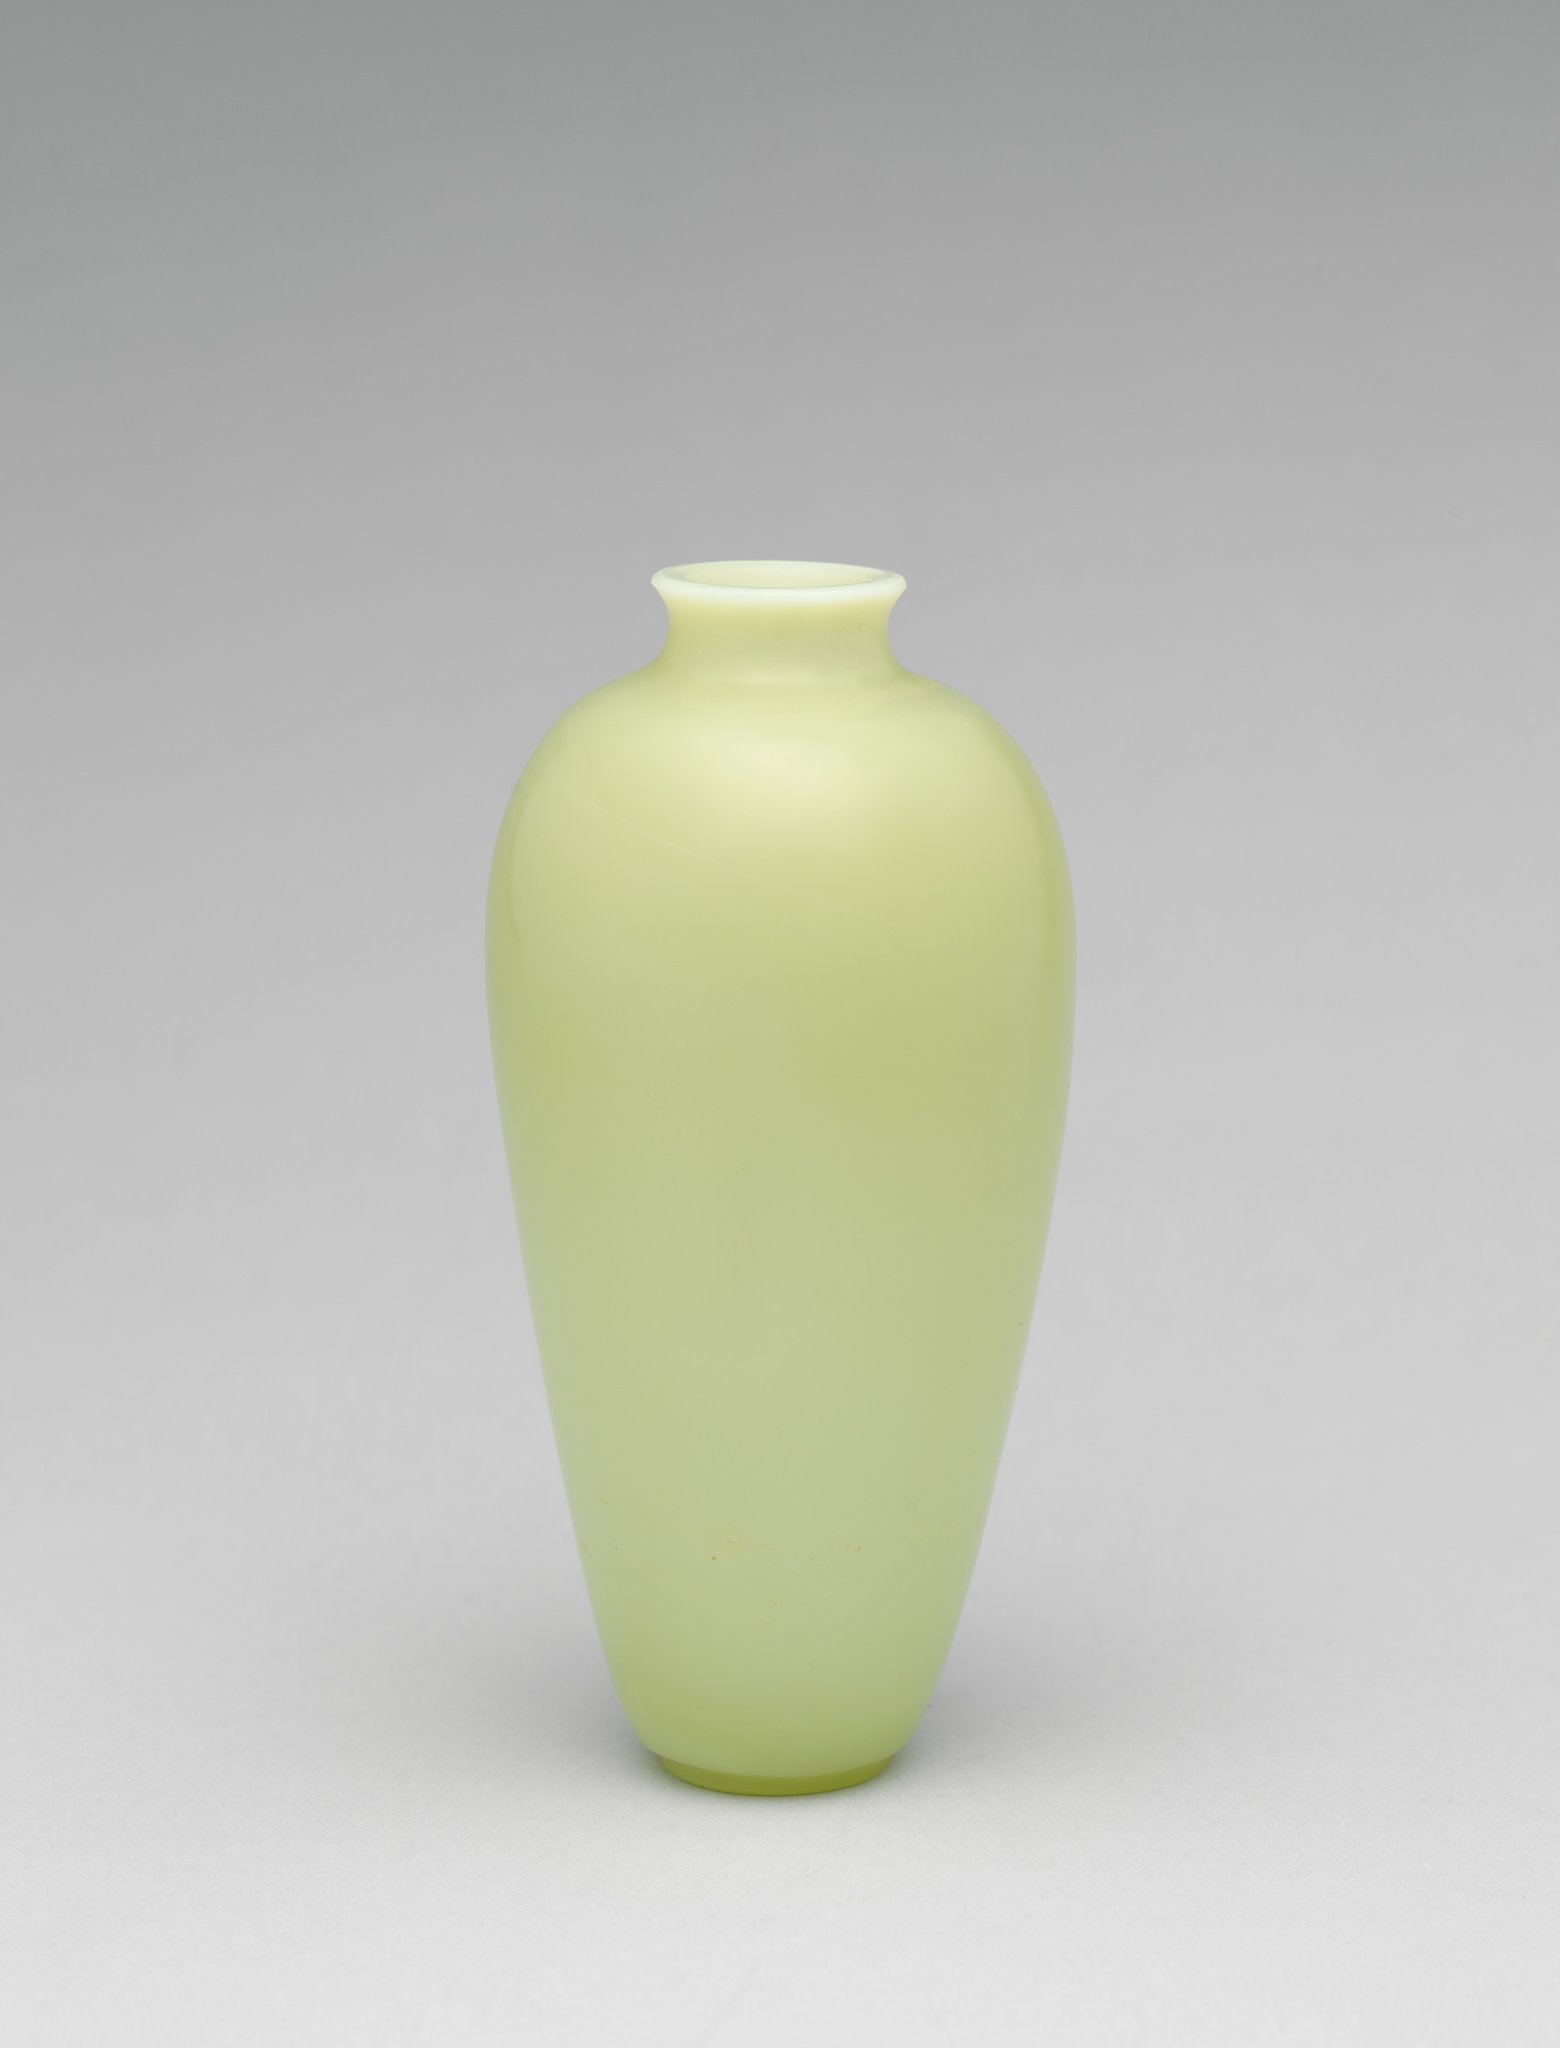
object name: vase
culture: chinese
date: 1736-1795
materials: glass